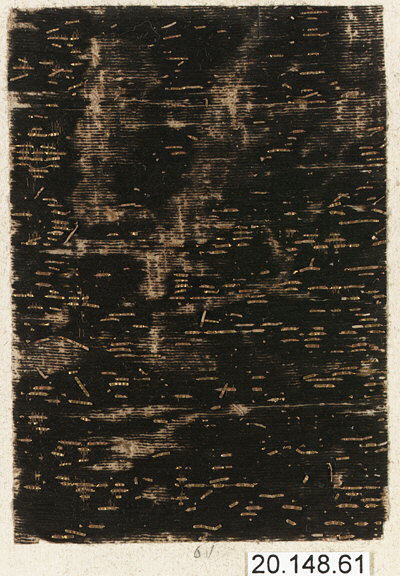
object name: piece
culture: japanese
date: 1401-1500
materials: silk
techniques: compound weave